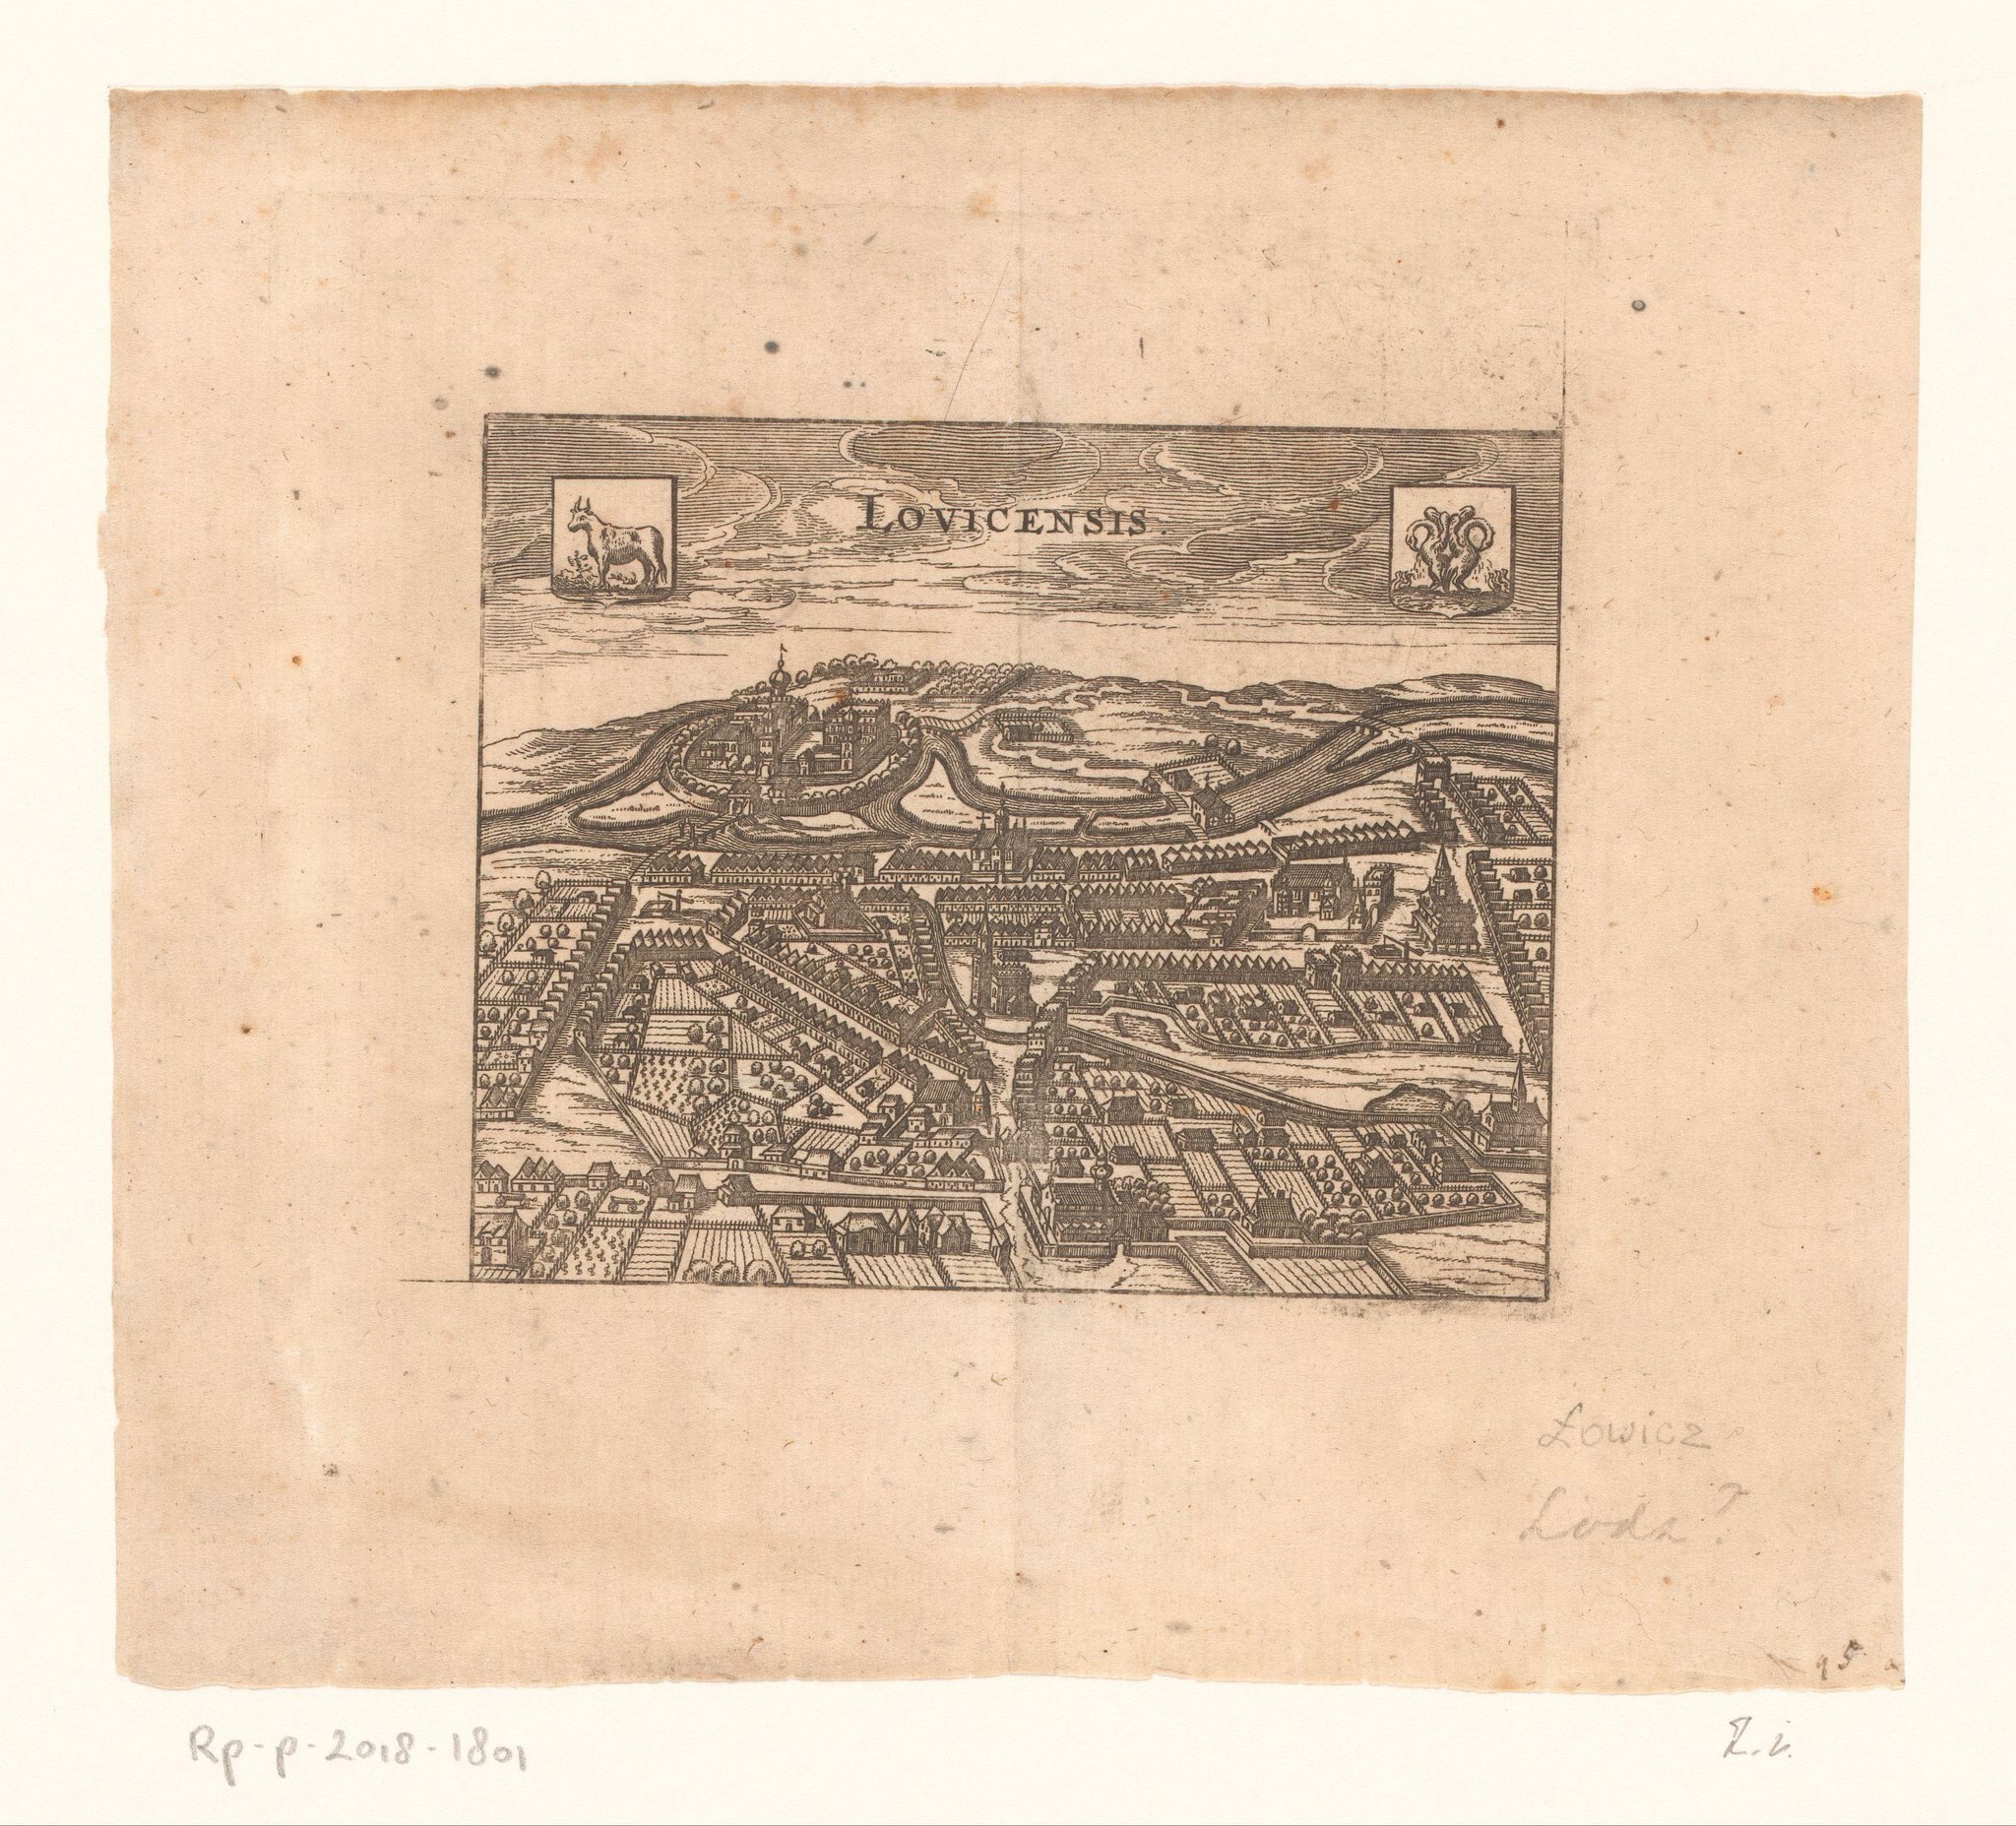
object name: print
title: Gezicht op Lowicz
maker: Anonymous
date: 1650-1749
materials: paper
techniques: etching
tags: coat of arms (as symbol of the state, etc.) (+ city; municipal), coat of arms (as symbol of the state, etc.) (+ province; provincial), prospect of city, town panorama, silhouette of city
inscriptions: collector's mark: Lugt 2228